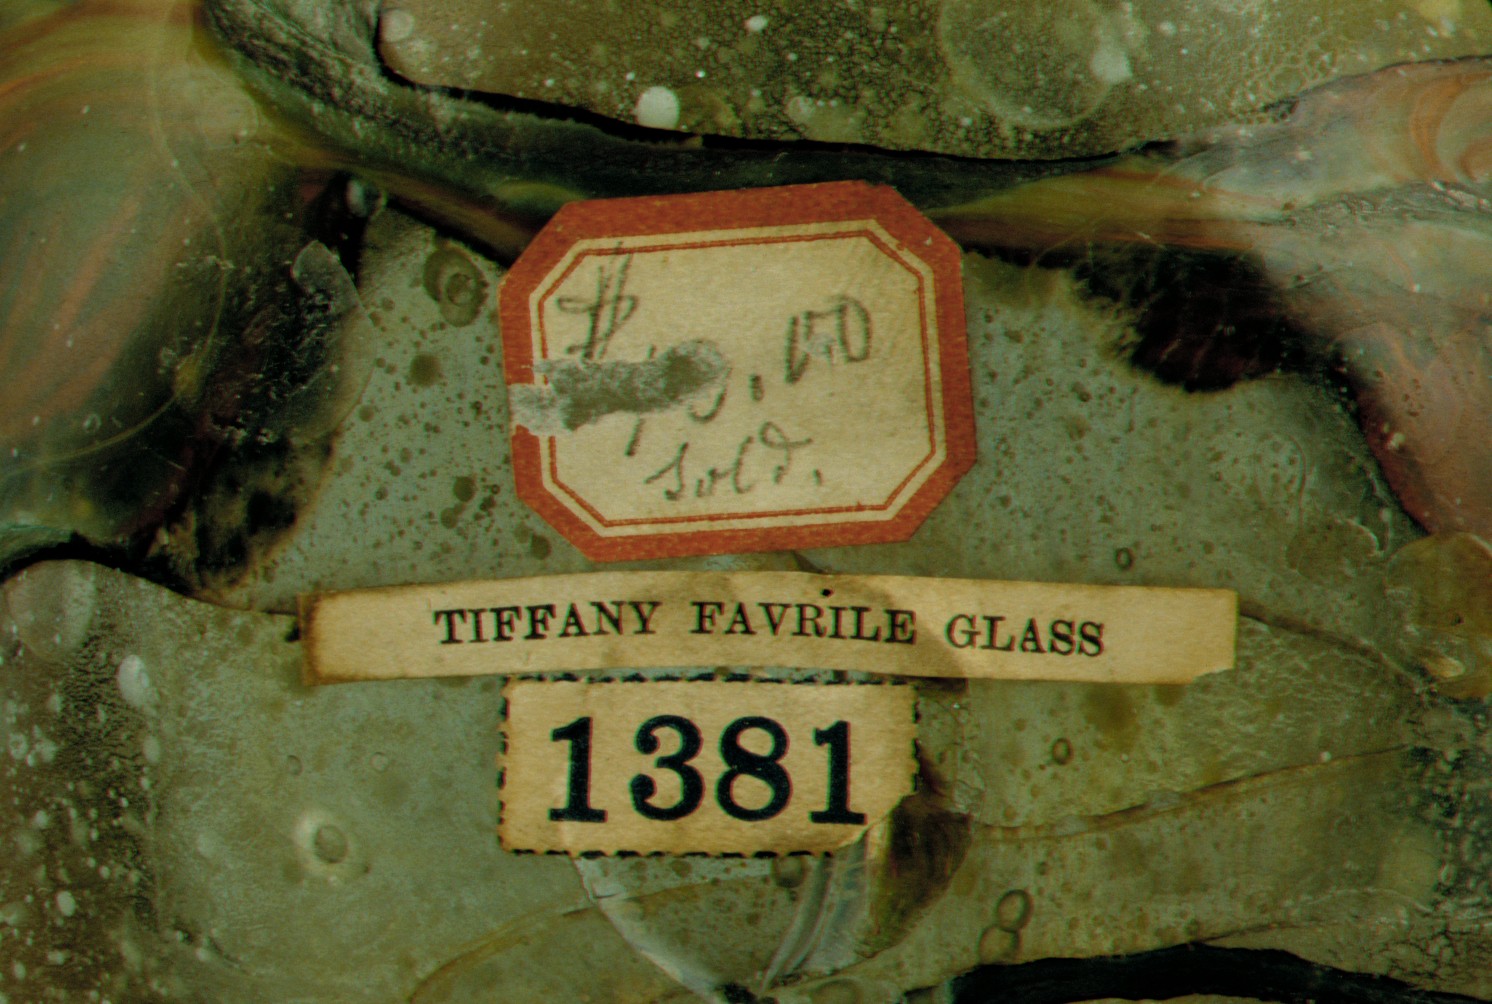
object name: vase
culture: american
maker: louis c. tiffany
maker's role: designer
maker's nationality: american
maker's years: 1848-1933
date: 1893-1896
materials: glass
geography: united states